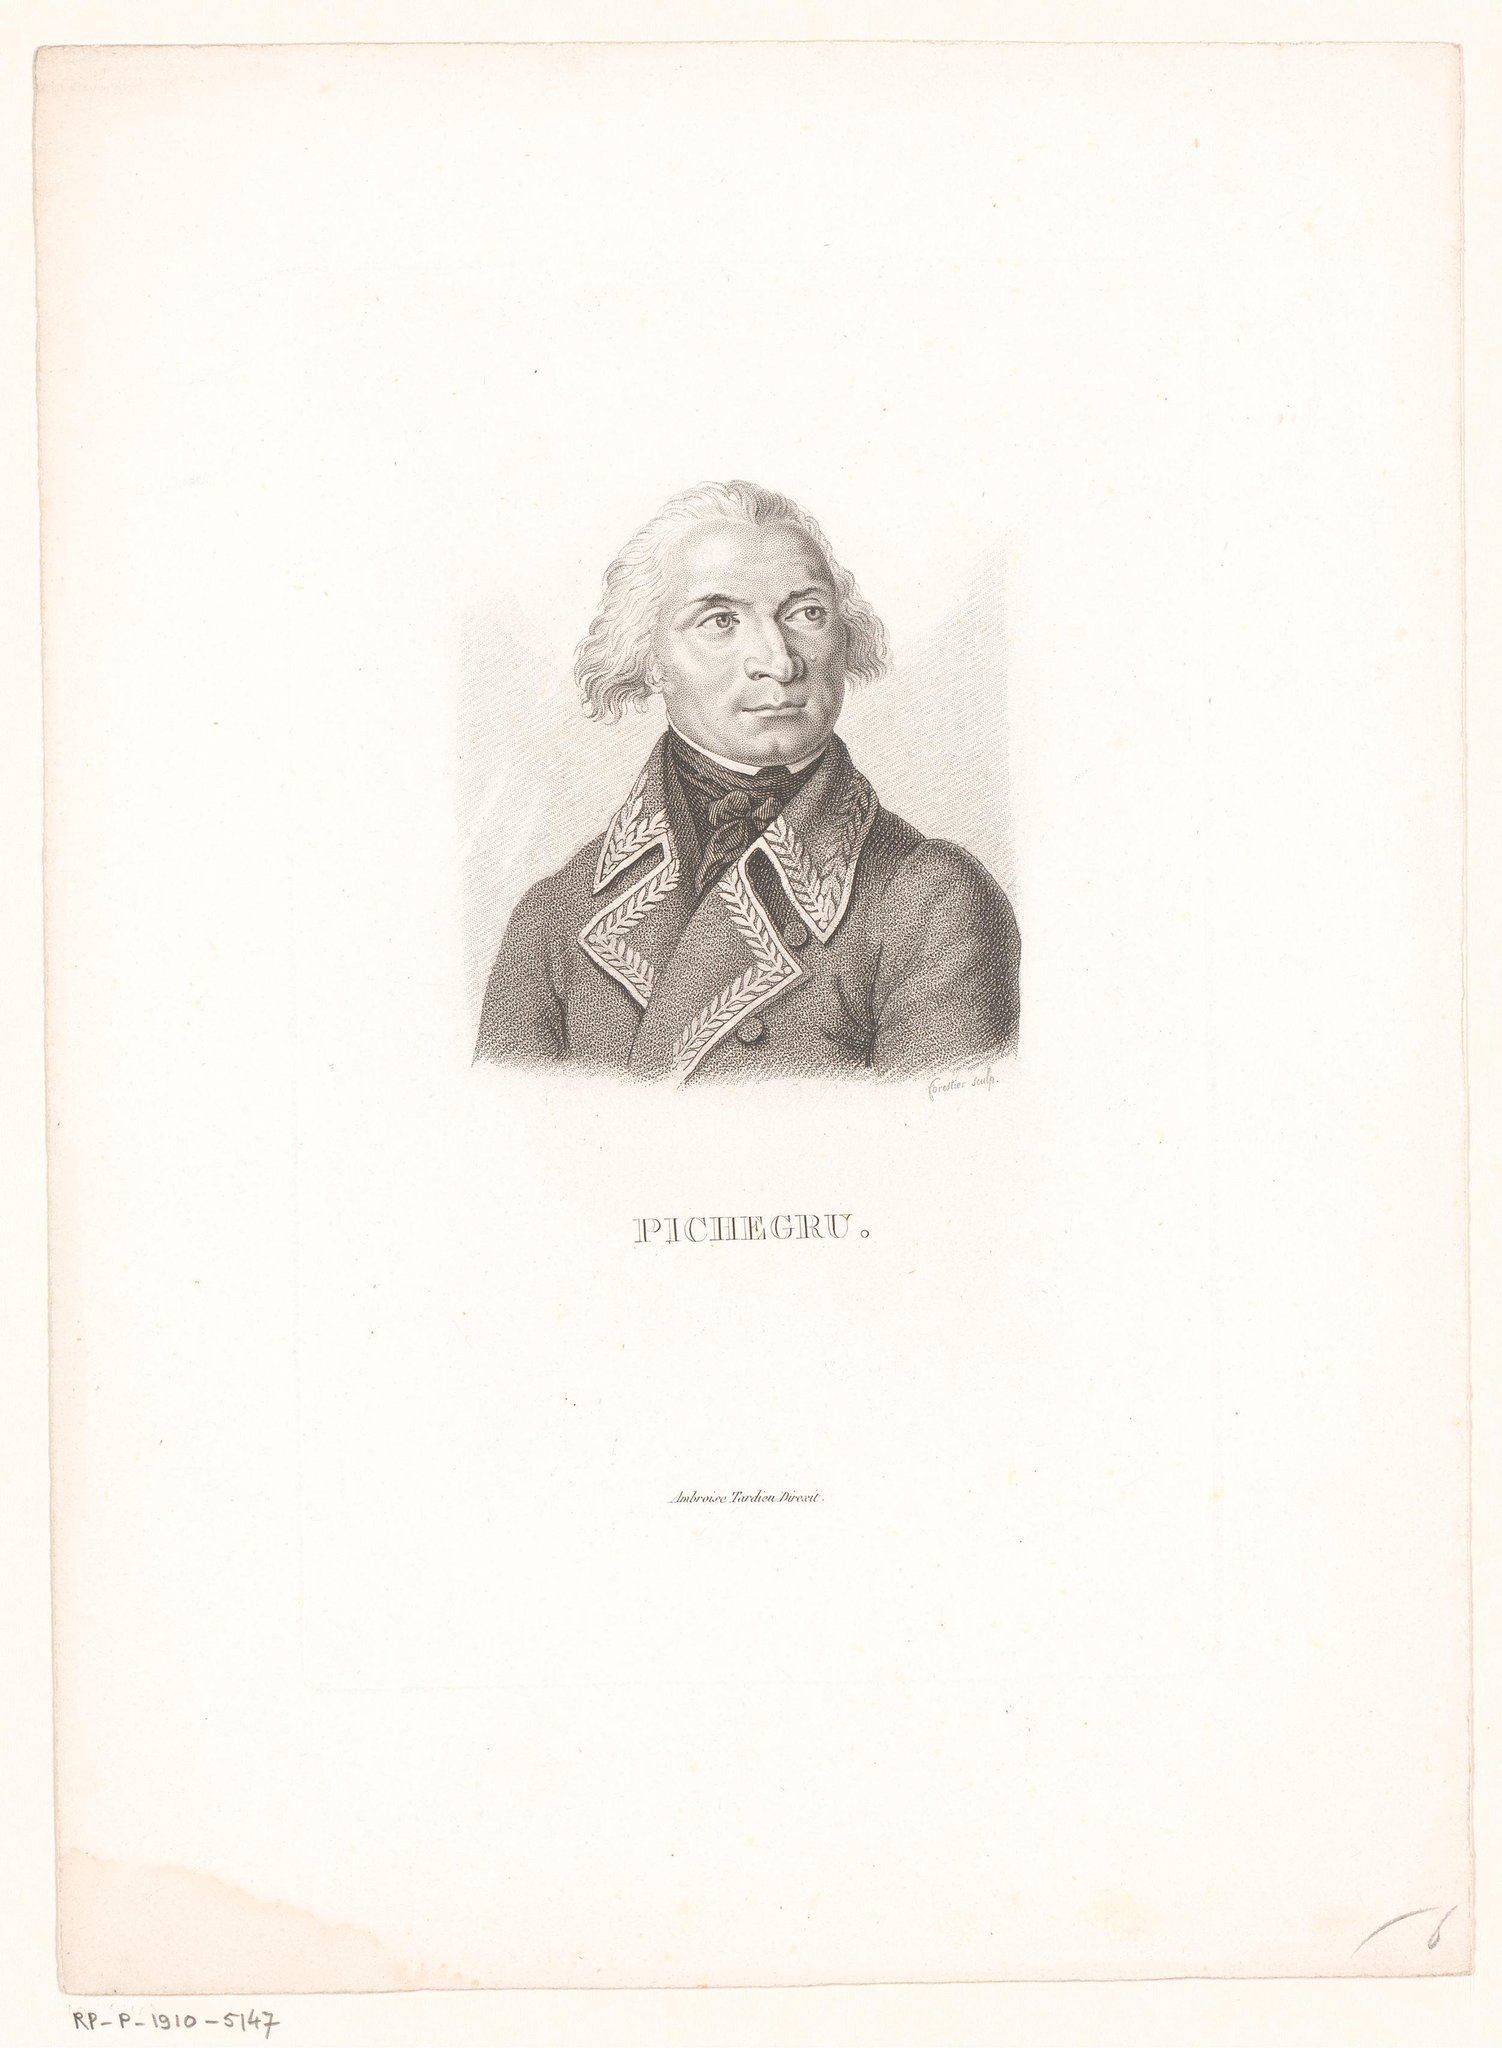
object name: print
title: Portret van Jean-Charles Pichegru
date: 1818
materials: paper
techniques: etching, roulette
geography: paris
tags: paris, politician, jean-charles pichegru, commander-in-chief, general, marshal, historical persons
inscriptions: collector's mark: Lugt 2228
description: Mogelijk prent uit: Tardieu, Ambroise. Portraits des généraux français, faisant suite aux "Victoires et conquêtes des Français". Parijs: Panckoucke, Charles Louis Fleury, ca. 1818.